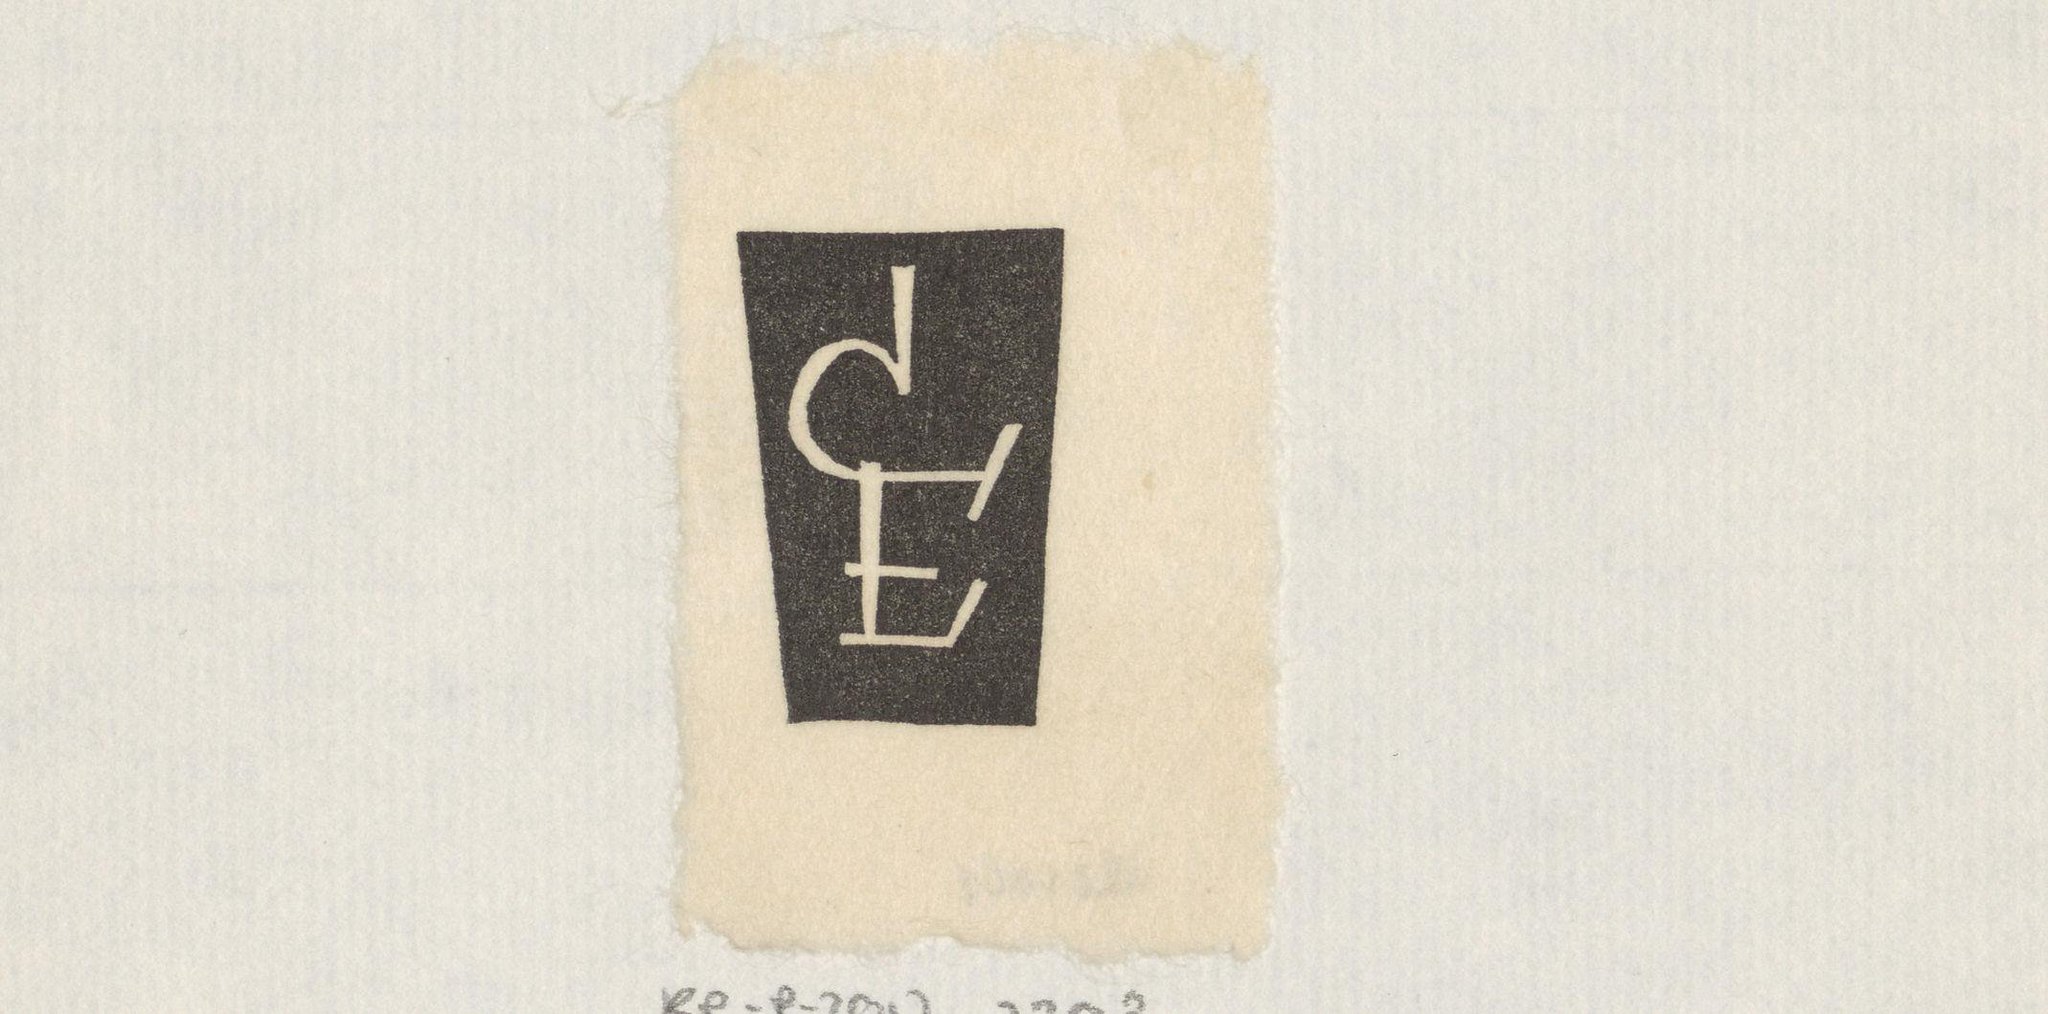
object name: bookplate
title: Ex libris van C.E.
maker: wilhelm sauer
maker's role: print maker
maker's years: 1892-1930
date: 1902-1930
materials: paper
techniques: woodcut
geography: austria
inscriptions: inscription: ‘Sauer’